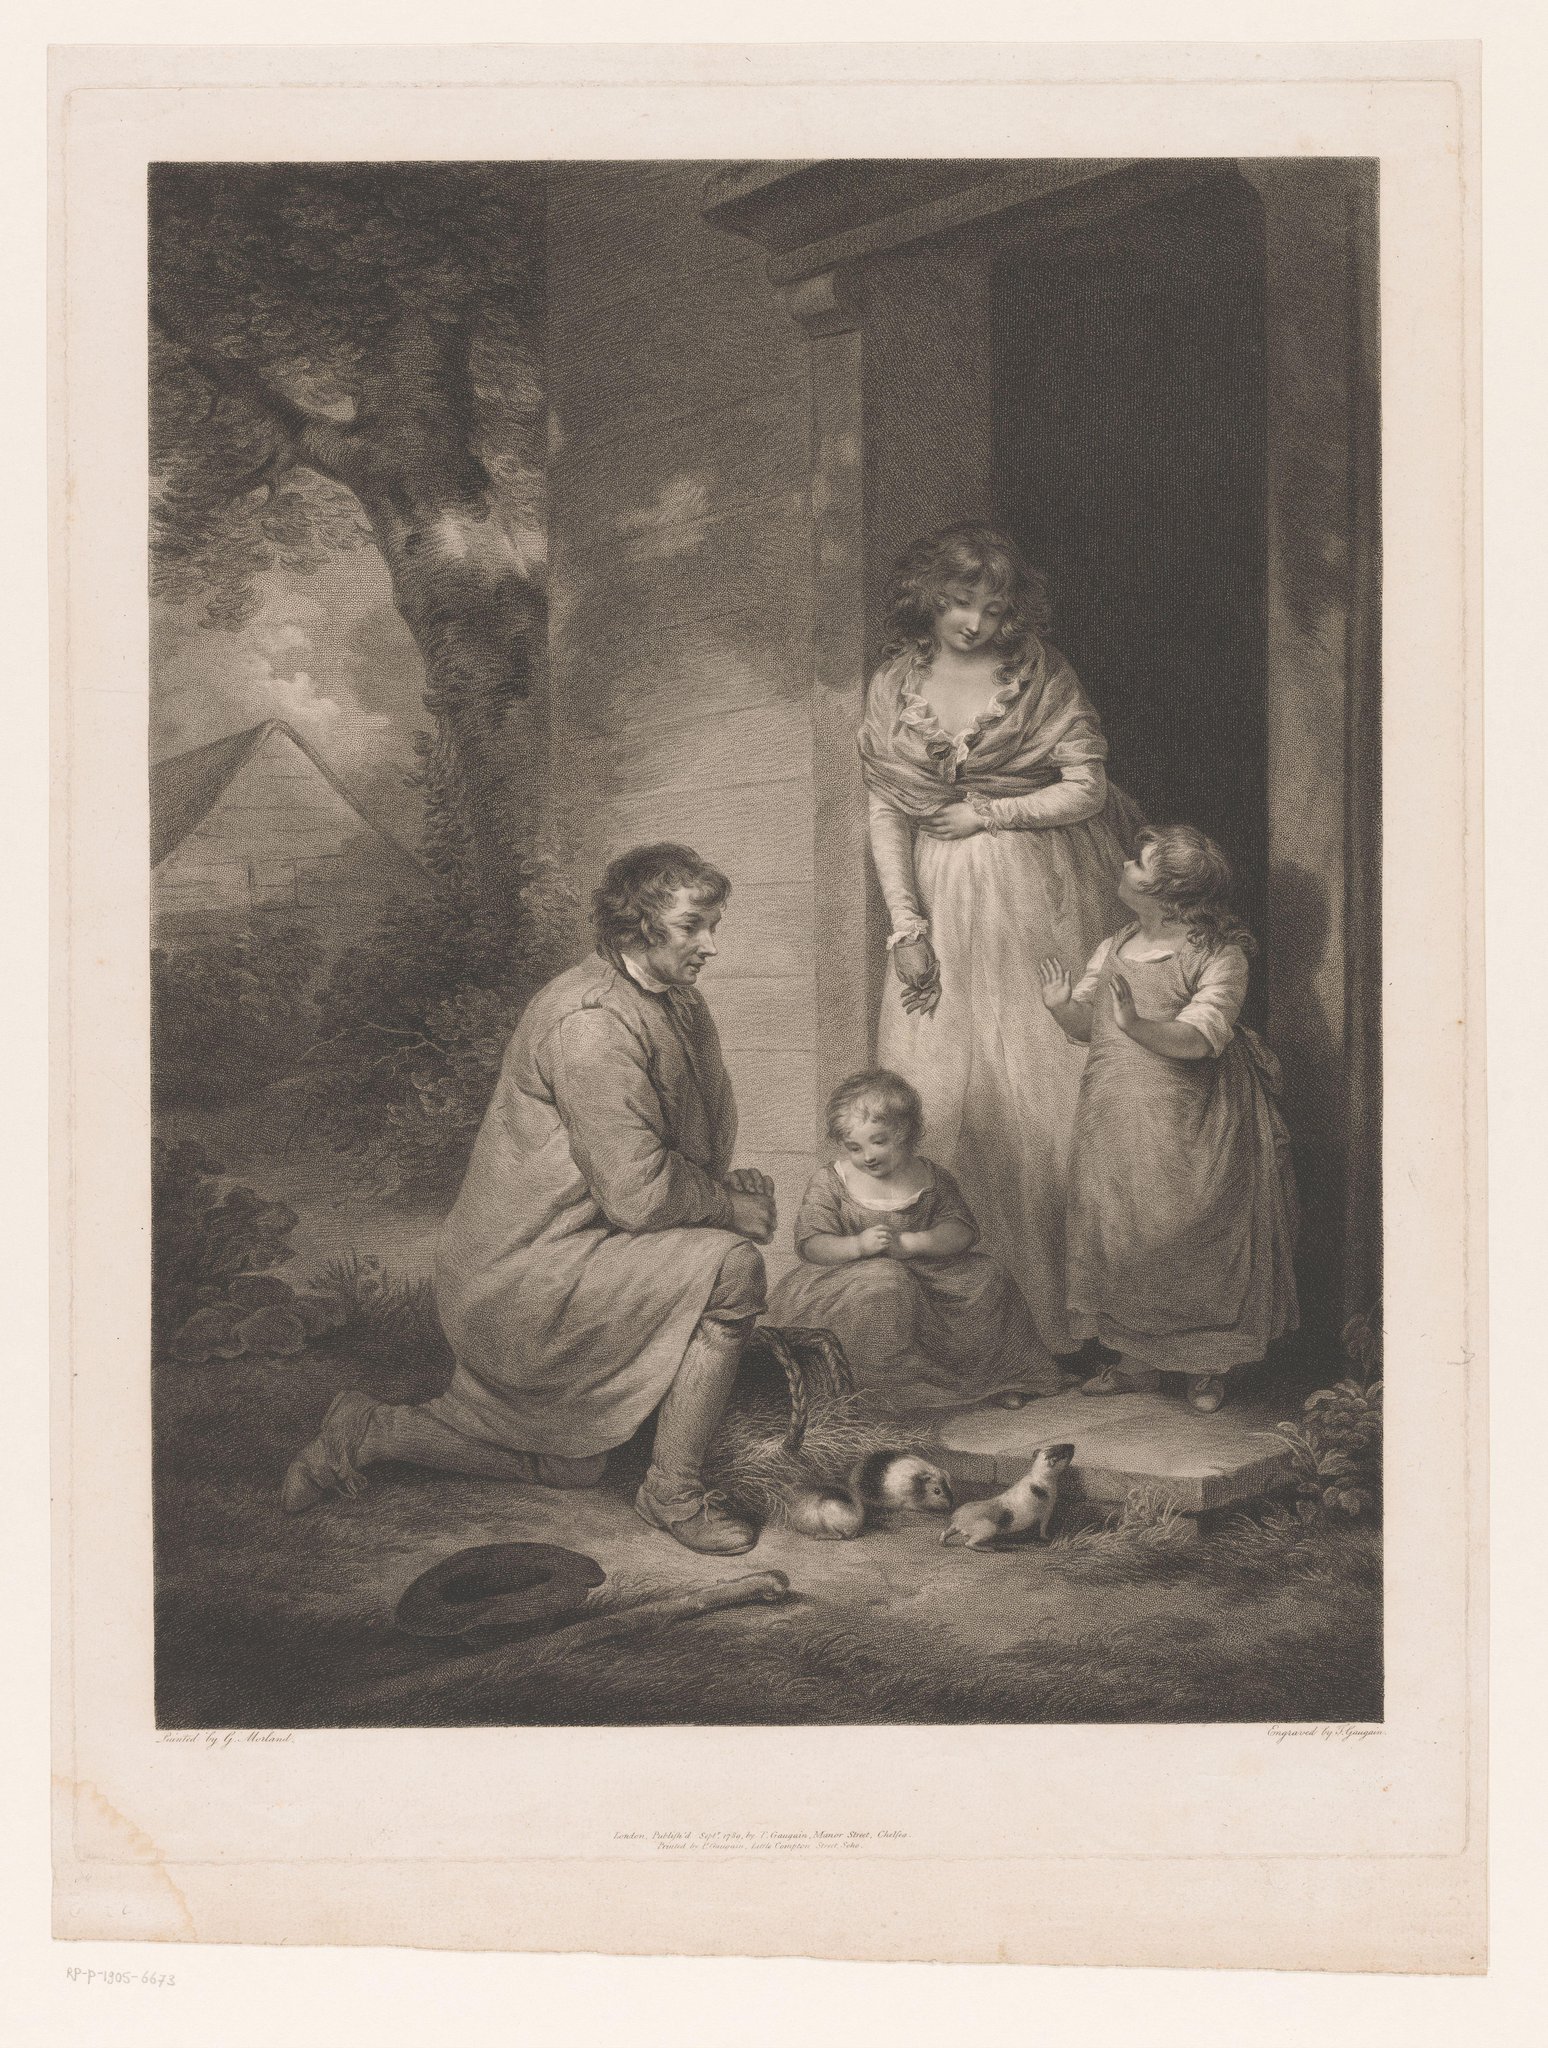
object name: print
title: Man toont cavia's aan een jonge vrouw en twee meisjes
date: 1789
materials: paper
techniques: engraving, etching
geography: london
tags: girl (child between toddler and youth), earning money with guinea-pig, taming, domestication of animals; tamed or domesticated animal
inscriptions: collector's mark: Lugt 2228